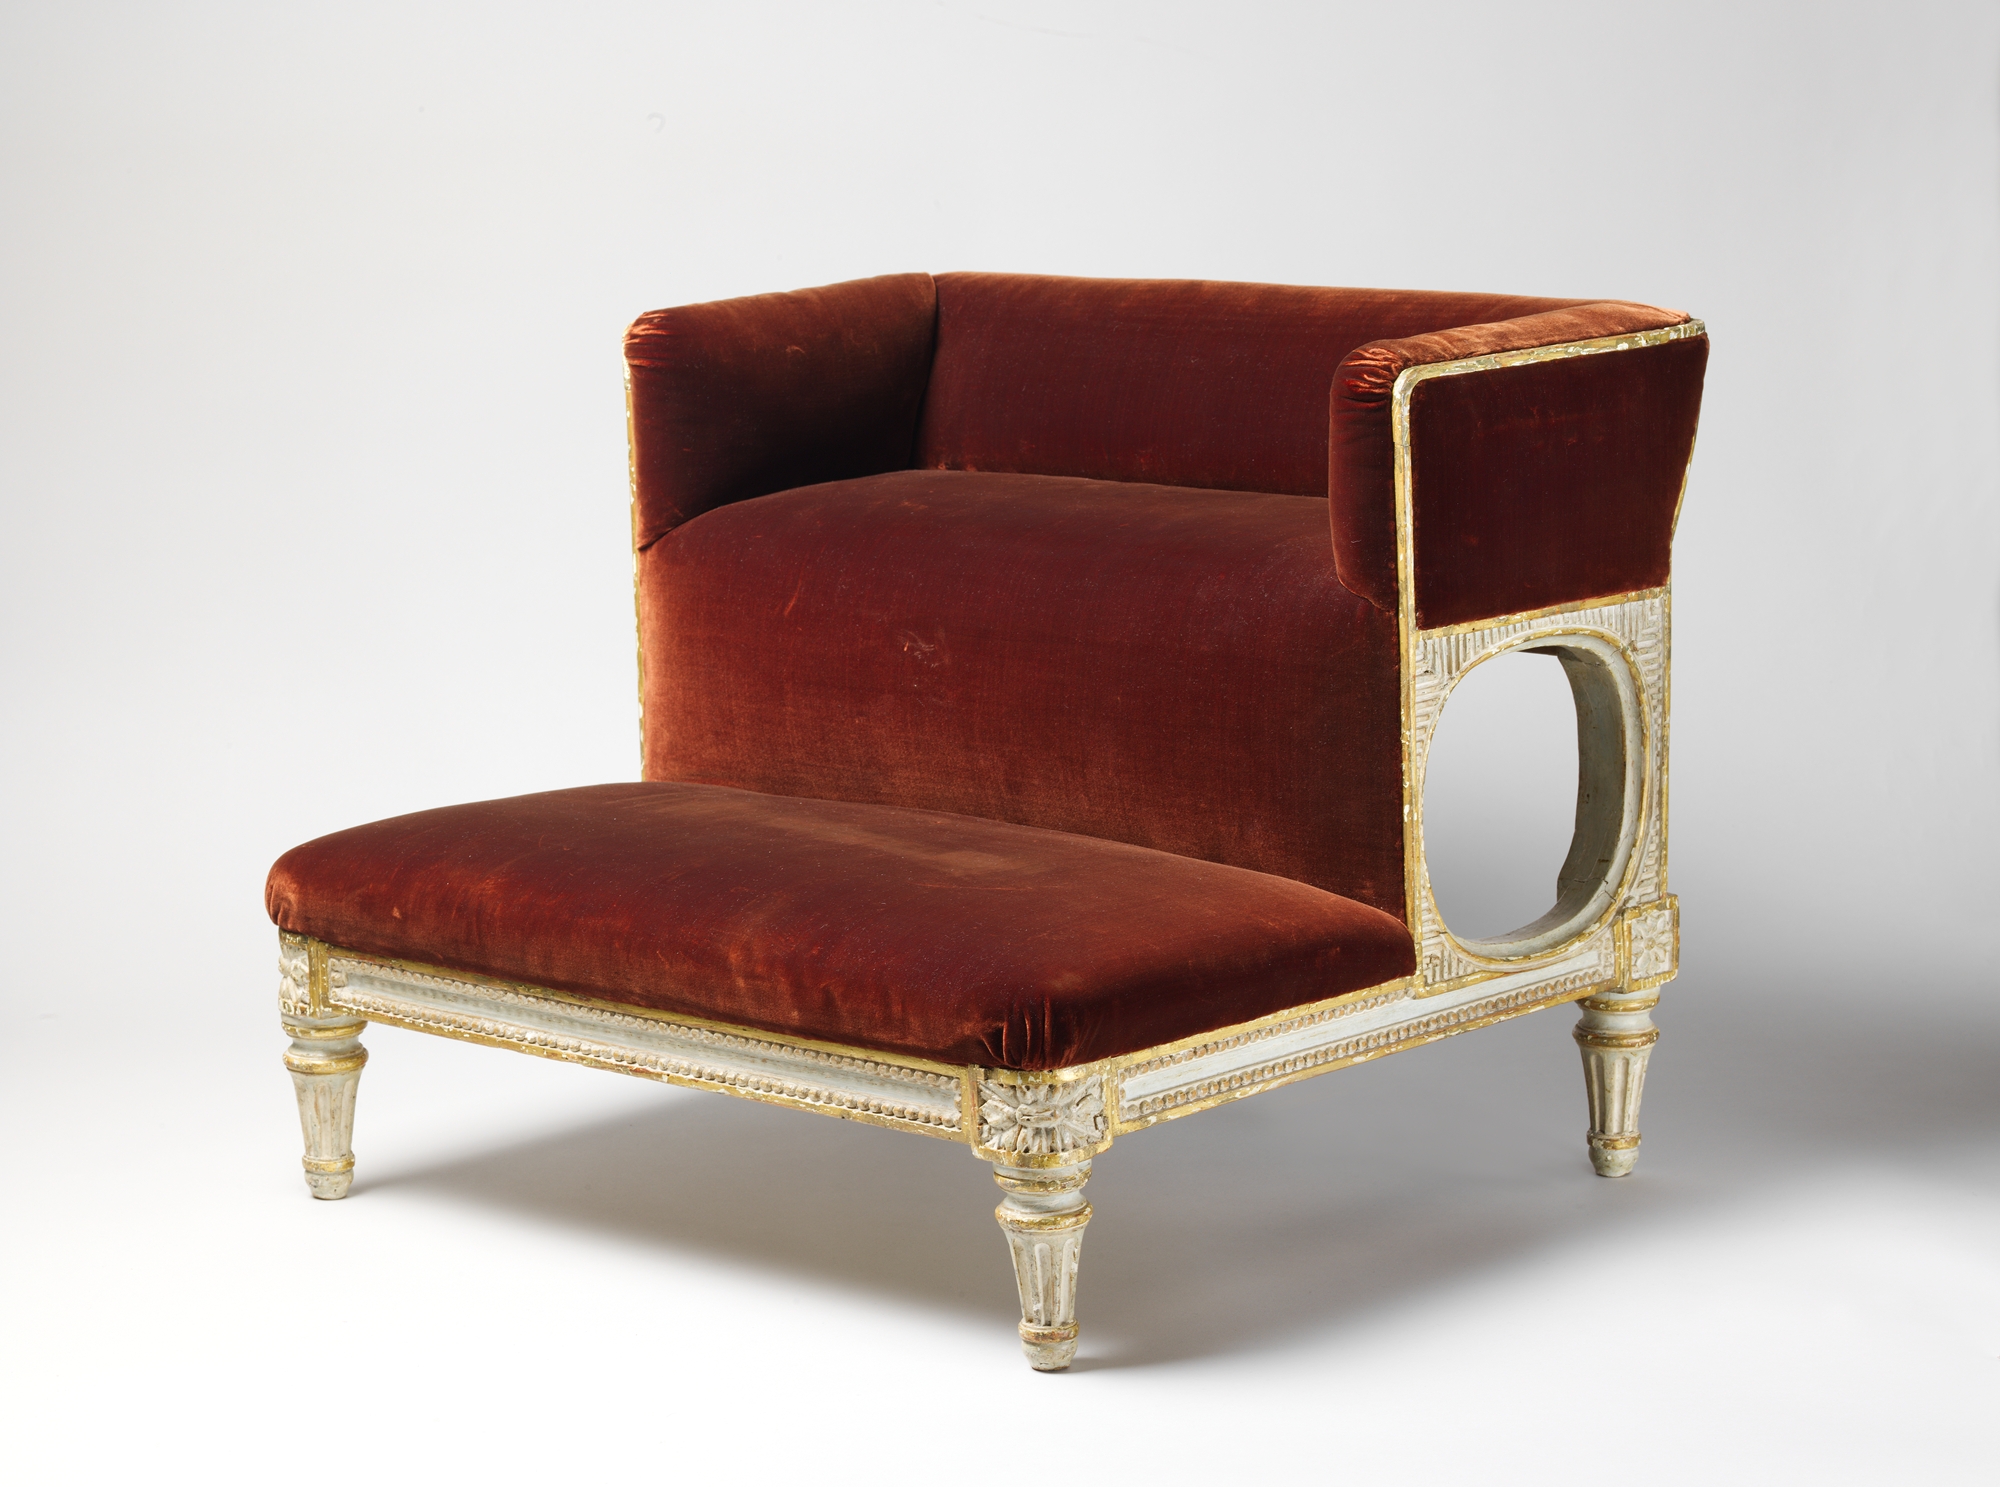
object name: bed step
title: Bed steps (Marchepied de lit)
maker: jean baptiste boulard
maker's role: maker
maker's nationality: french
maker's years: 1725-1789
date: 1767-1800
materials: wood, silk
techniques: carving, damask, gilding, painting